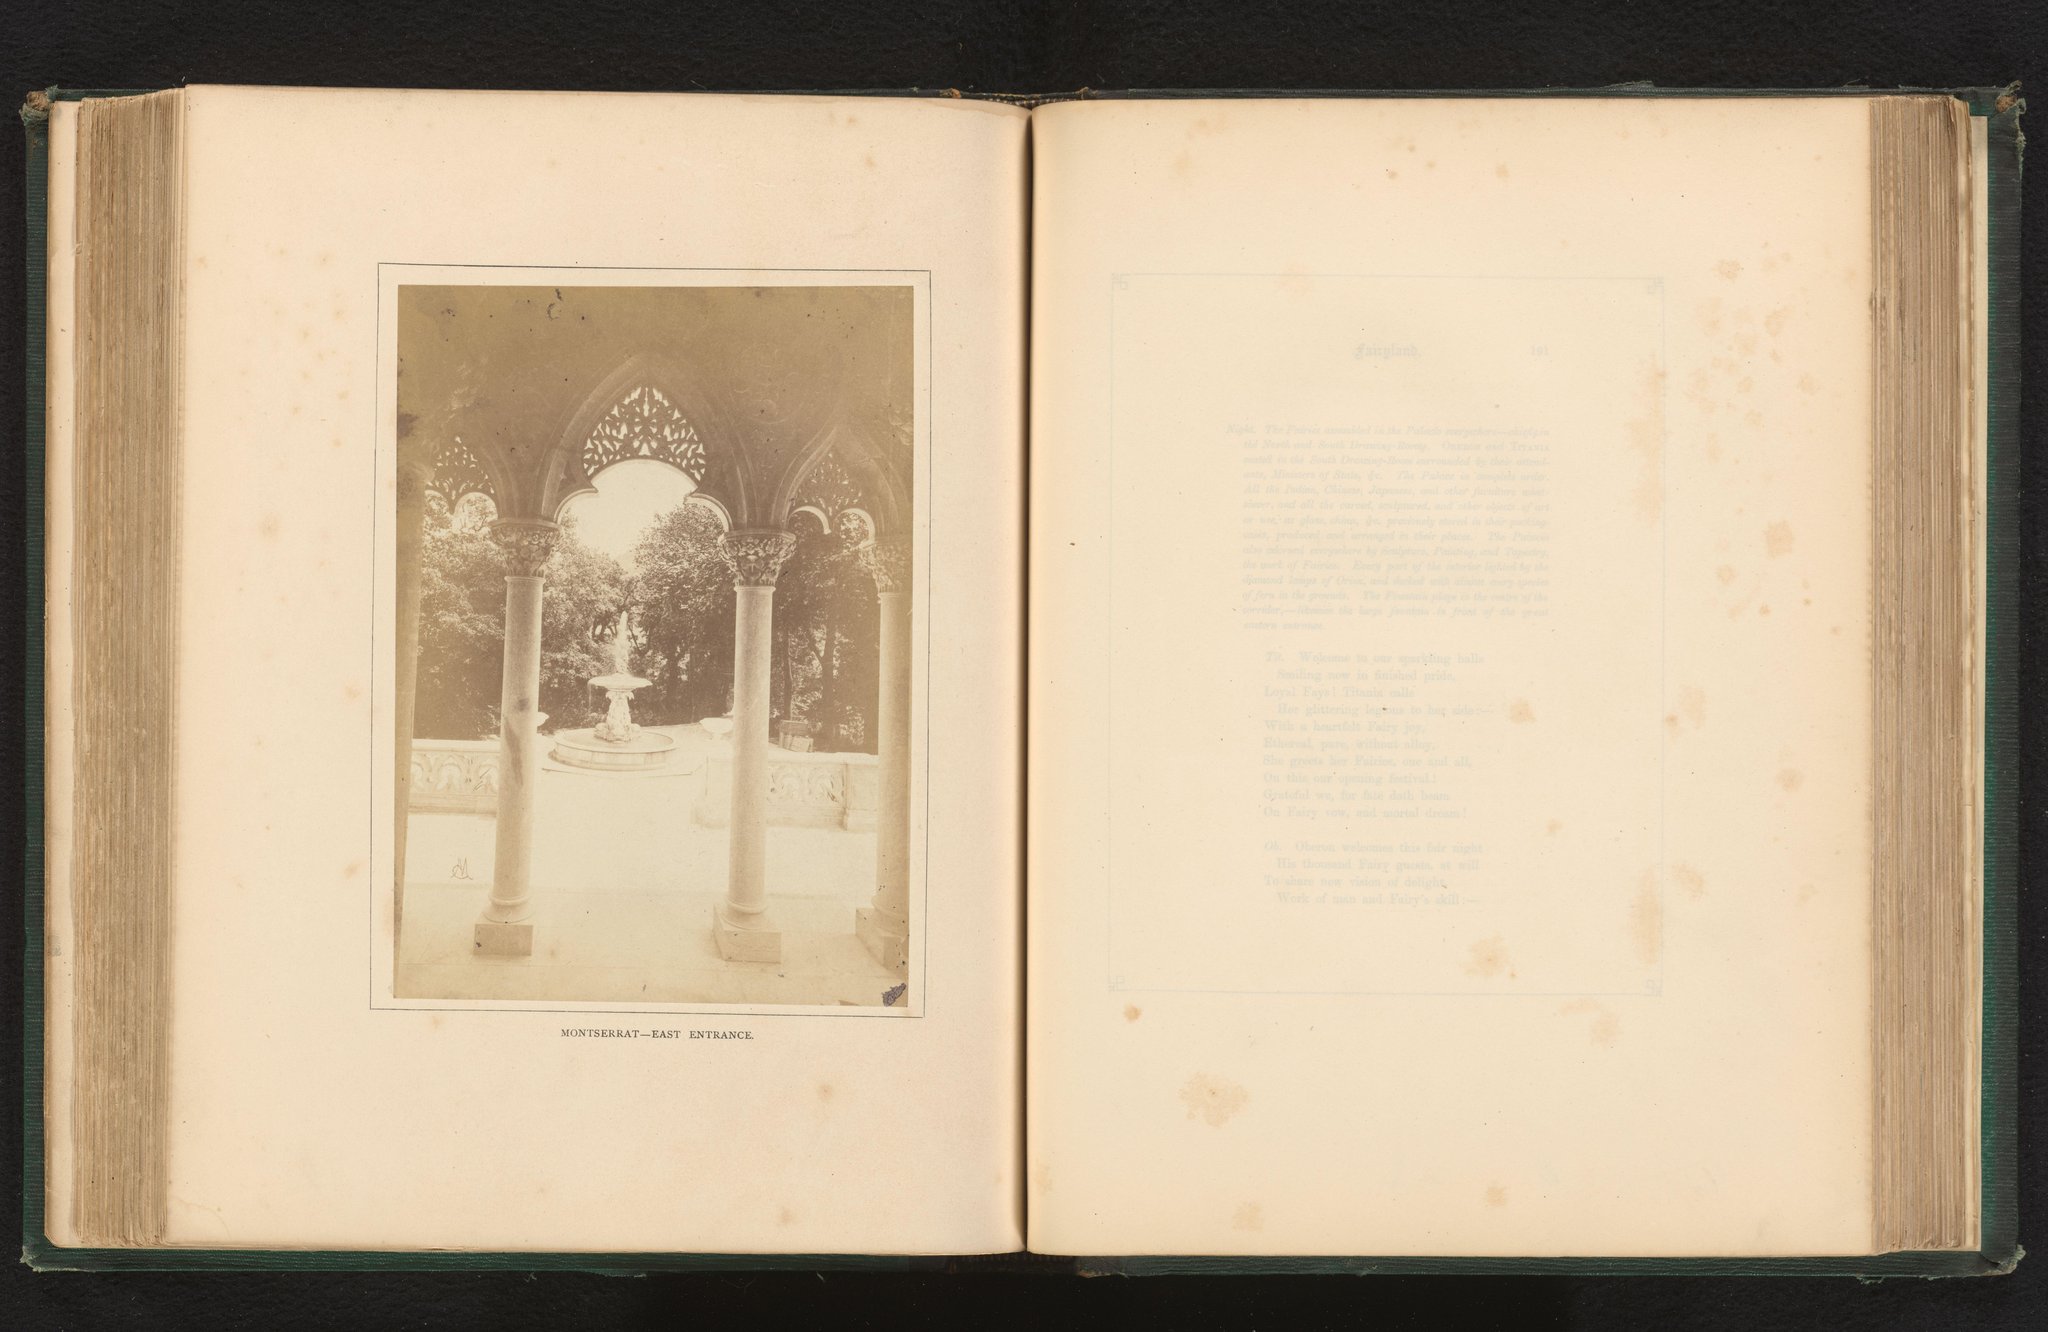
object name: photograph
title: Montserrat - East Entrance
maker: Anonymous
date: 1865-1870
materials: paper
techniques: albumen print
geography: sintra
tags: colonnade, gate, entrance, ornamental fountain